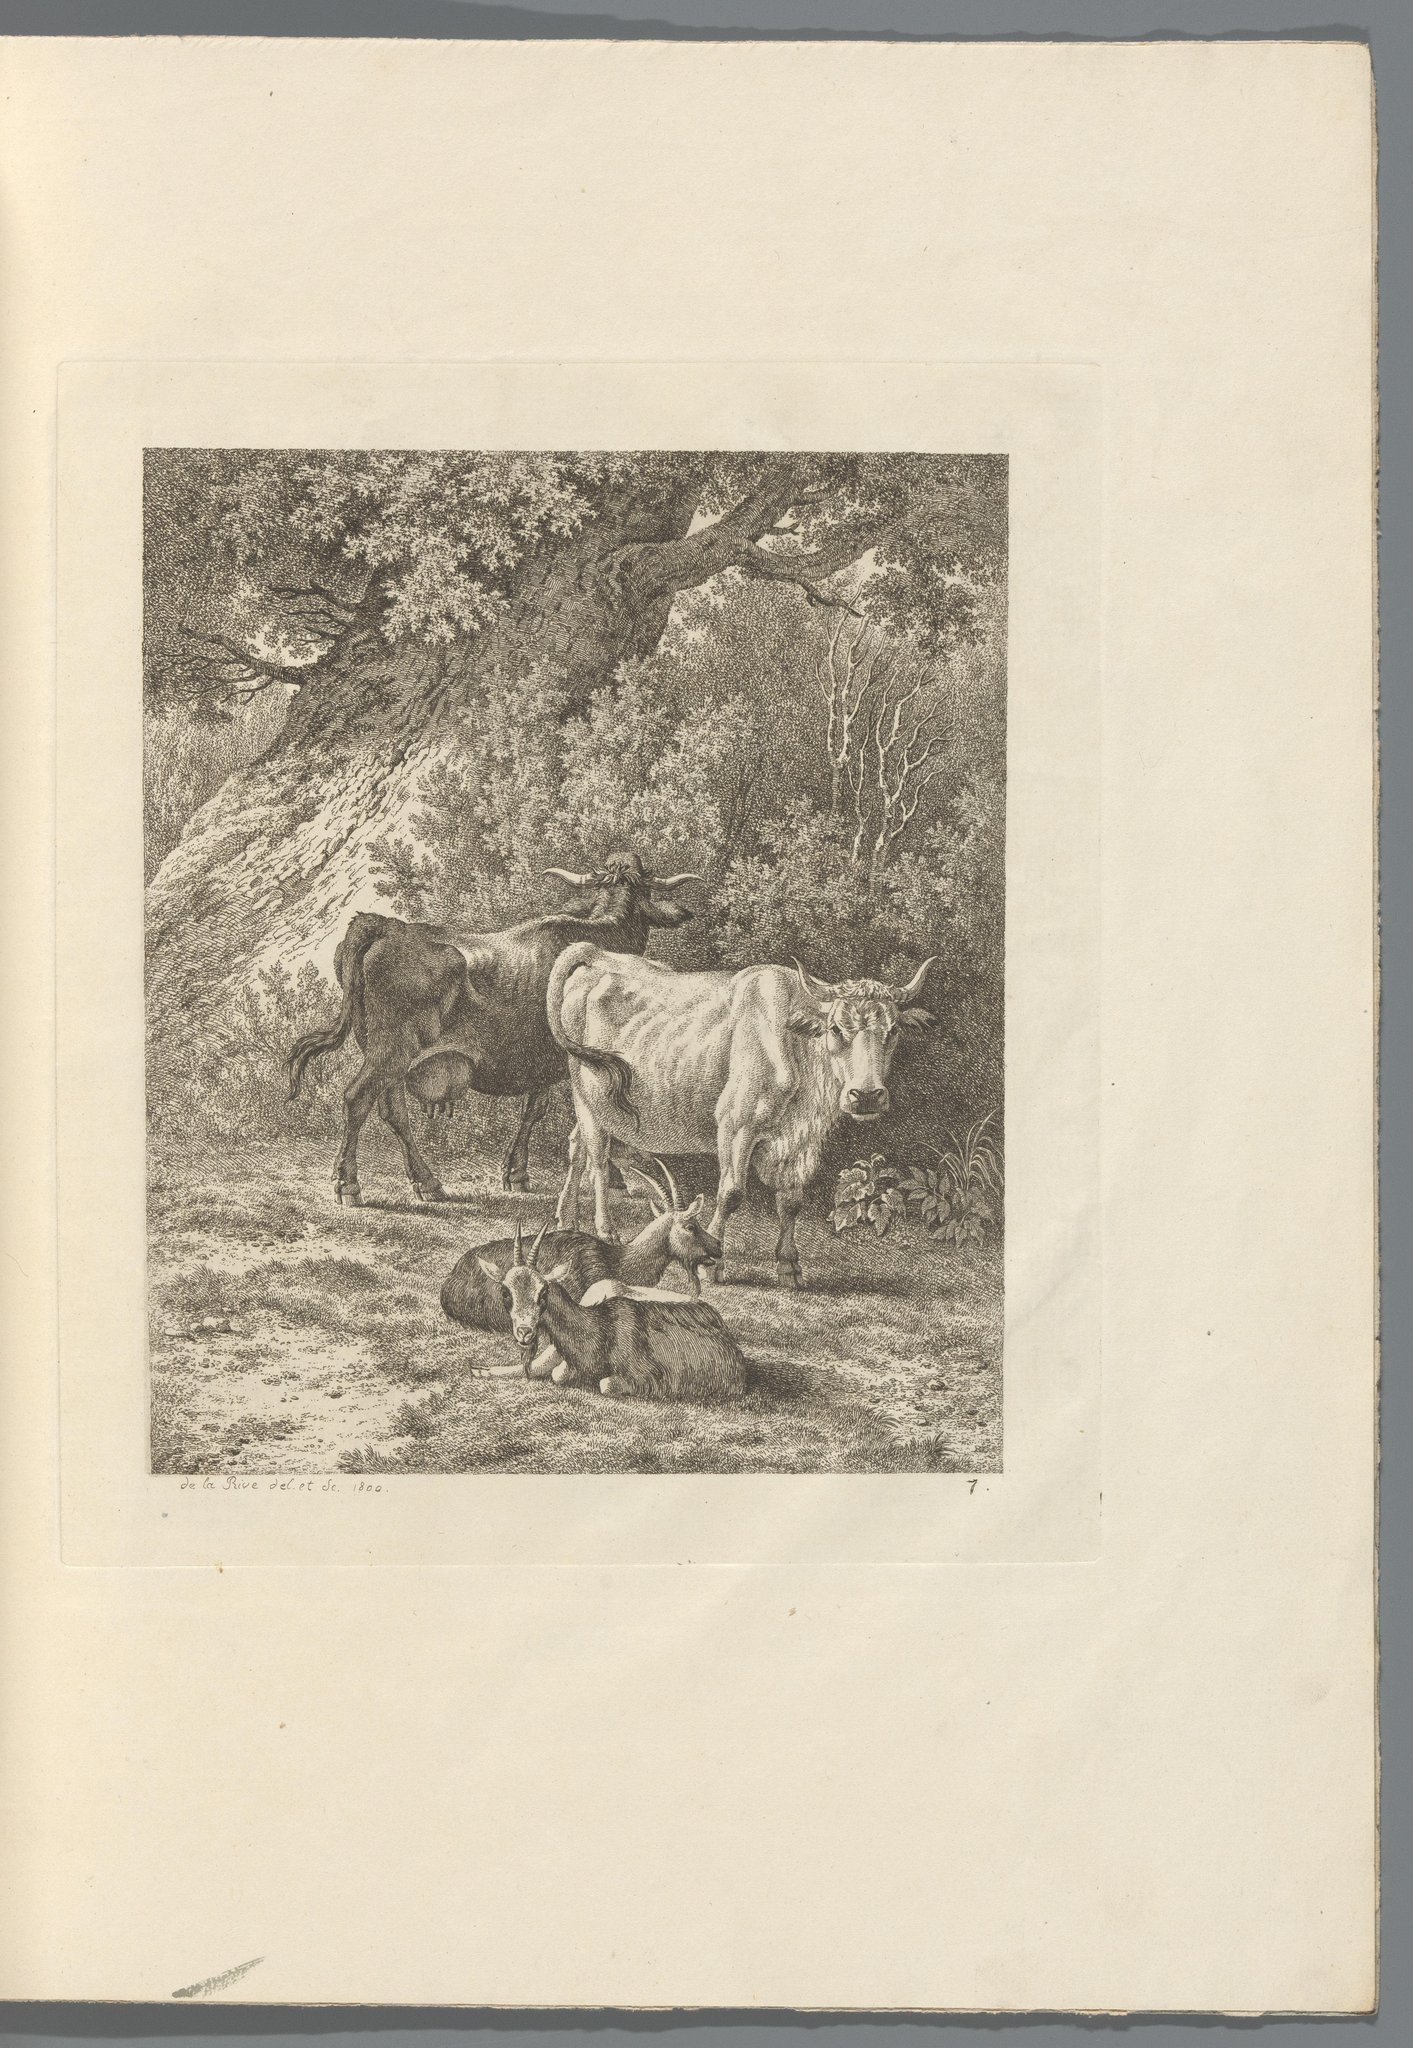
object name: print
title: Essais d'eau forte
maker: pierre-louis de la rive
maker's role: draughtsman, print maker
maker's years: 1753-1817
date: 1800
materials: paper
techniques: etching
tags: goat, bovine cattle, landscapes (+ landscape with figures, staffage)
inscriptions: collector's mark: Lugt 2228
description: Deze prent maakt deel uit van een album met acht prenten.